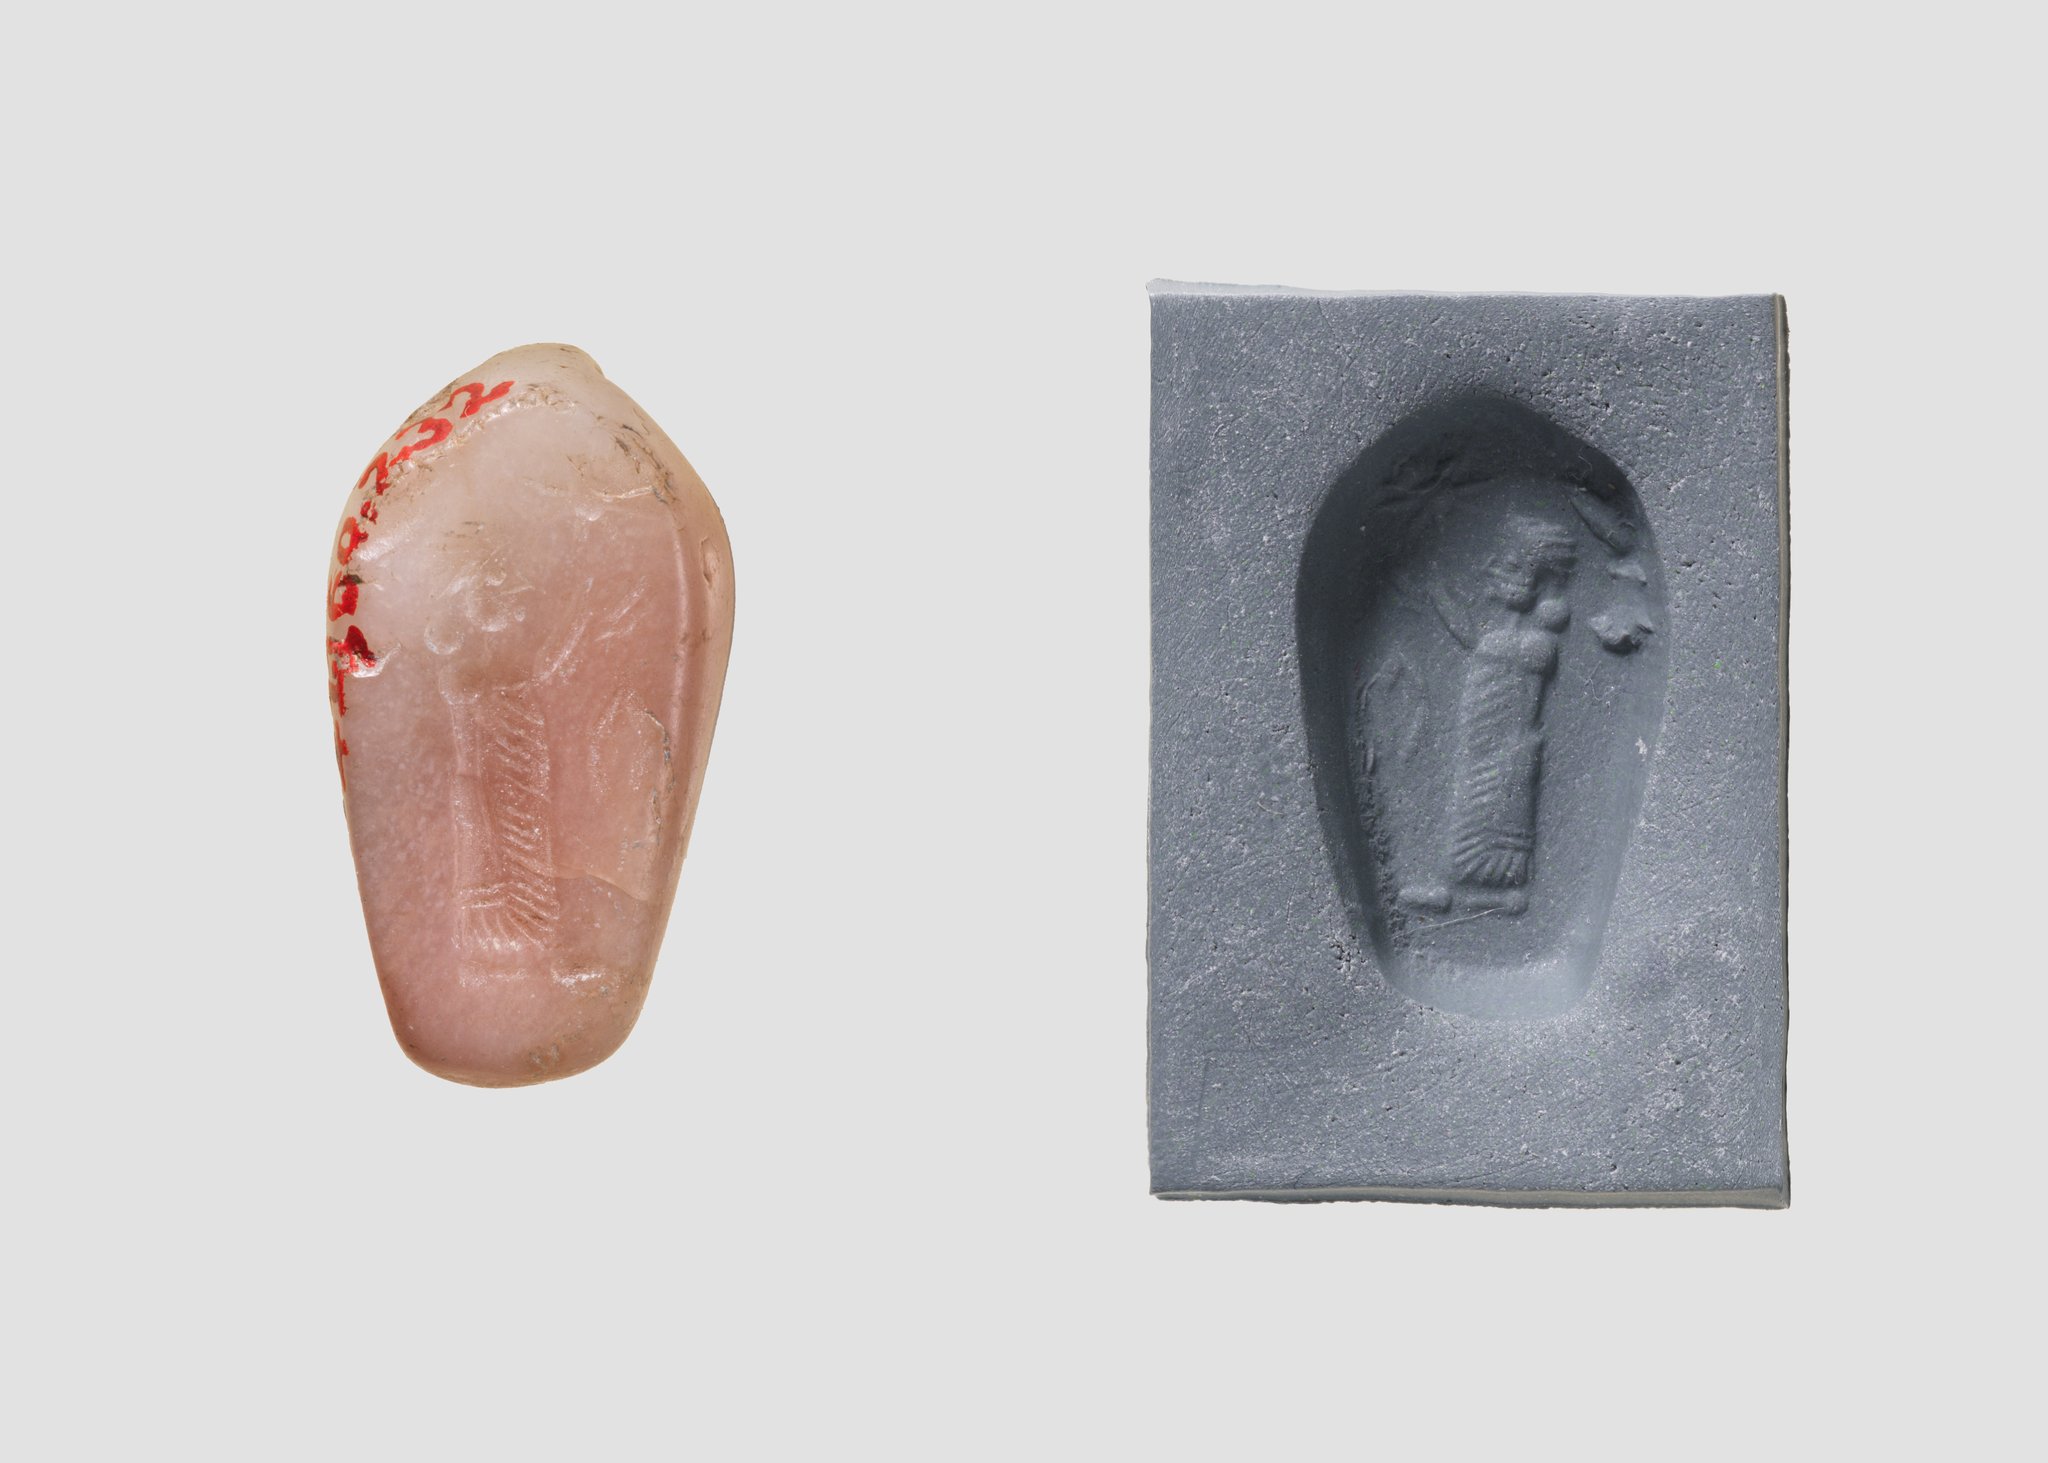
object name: stamp seal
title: Stamp seal (duck-shaped) with cultic scene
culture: assyro-babylonian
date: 734-501 BCE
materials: stone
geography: levant or mesopotamia (?)